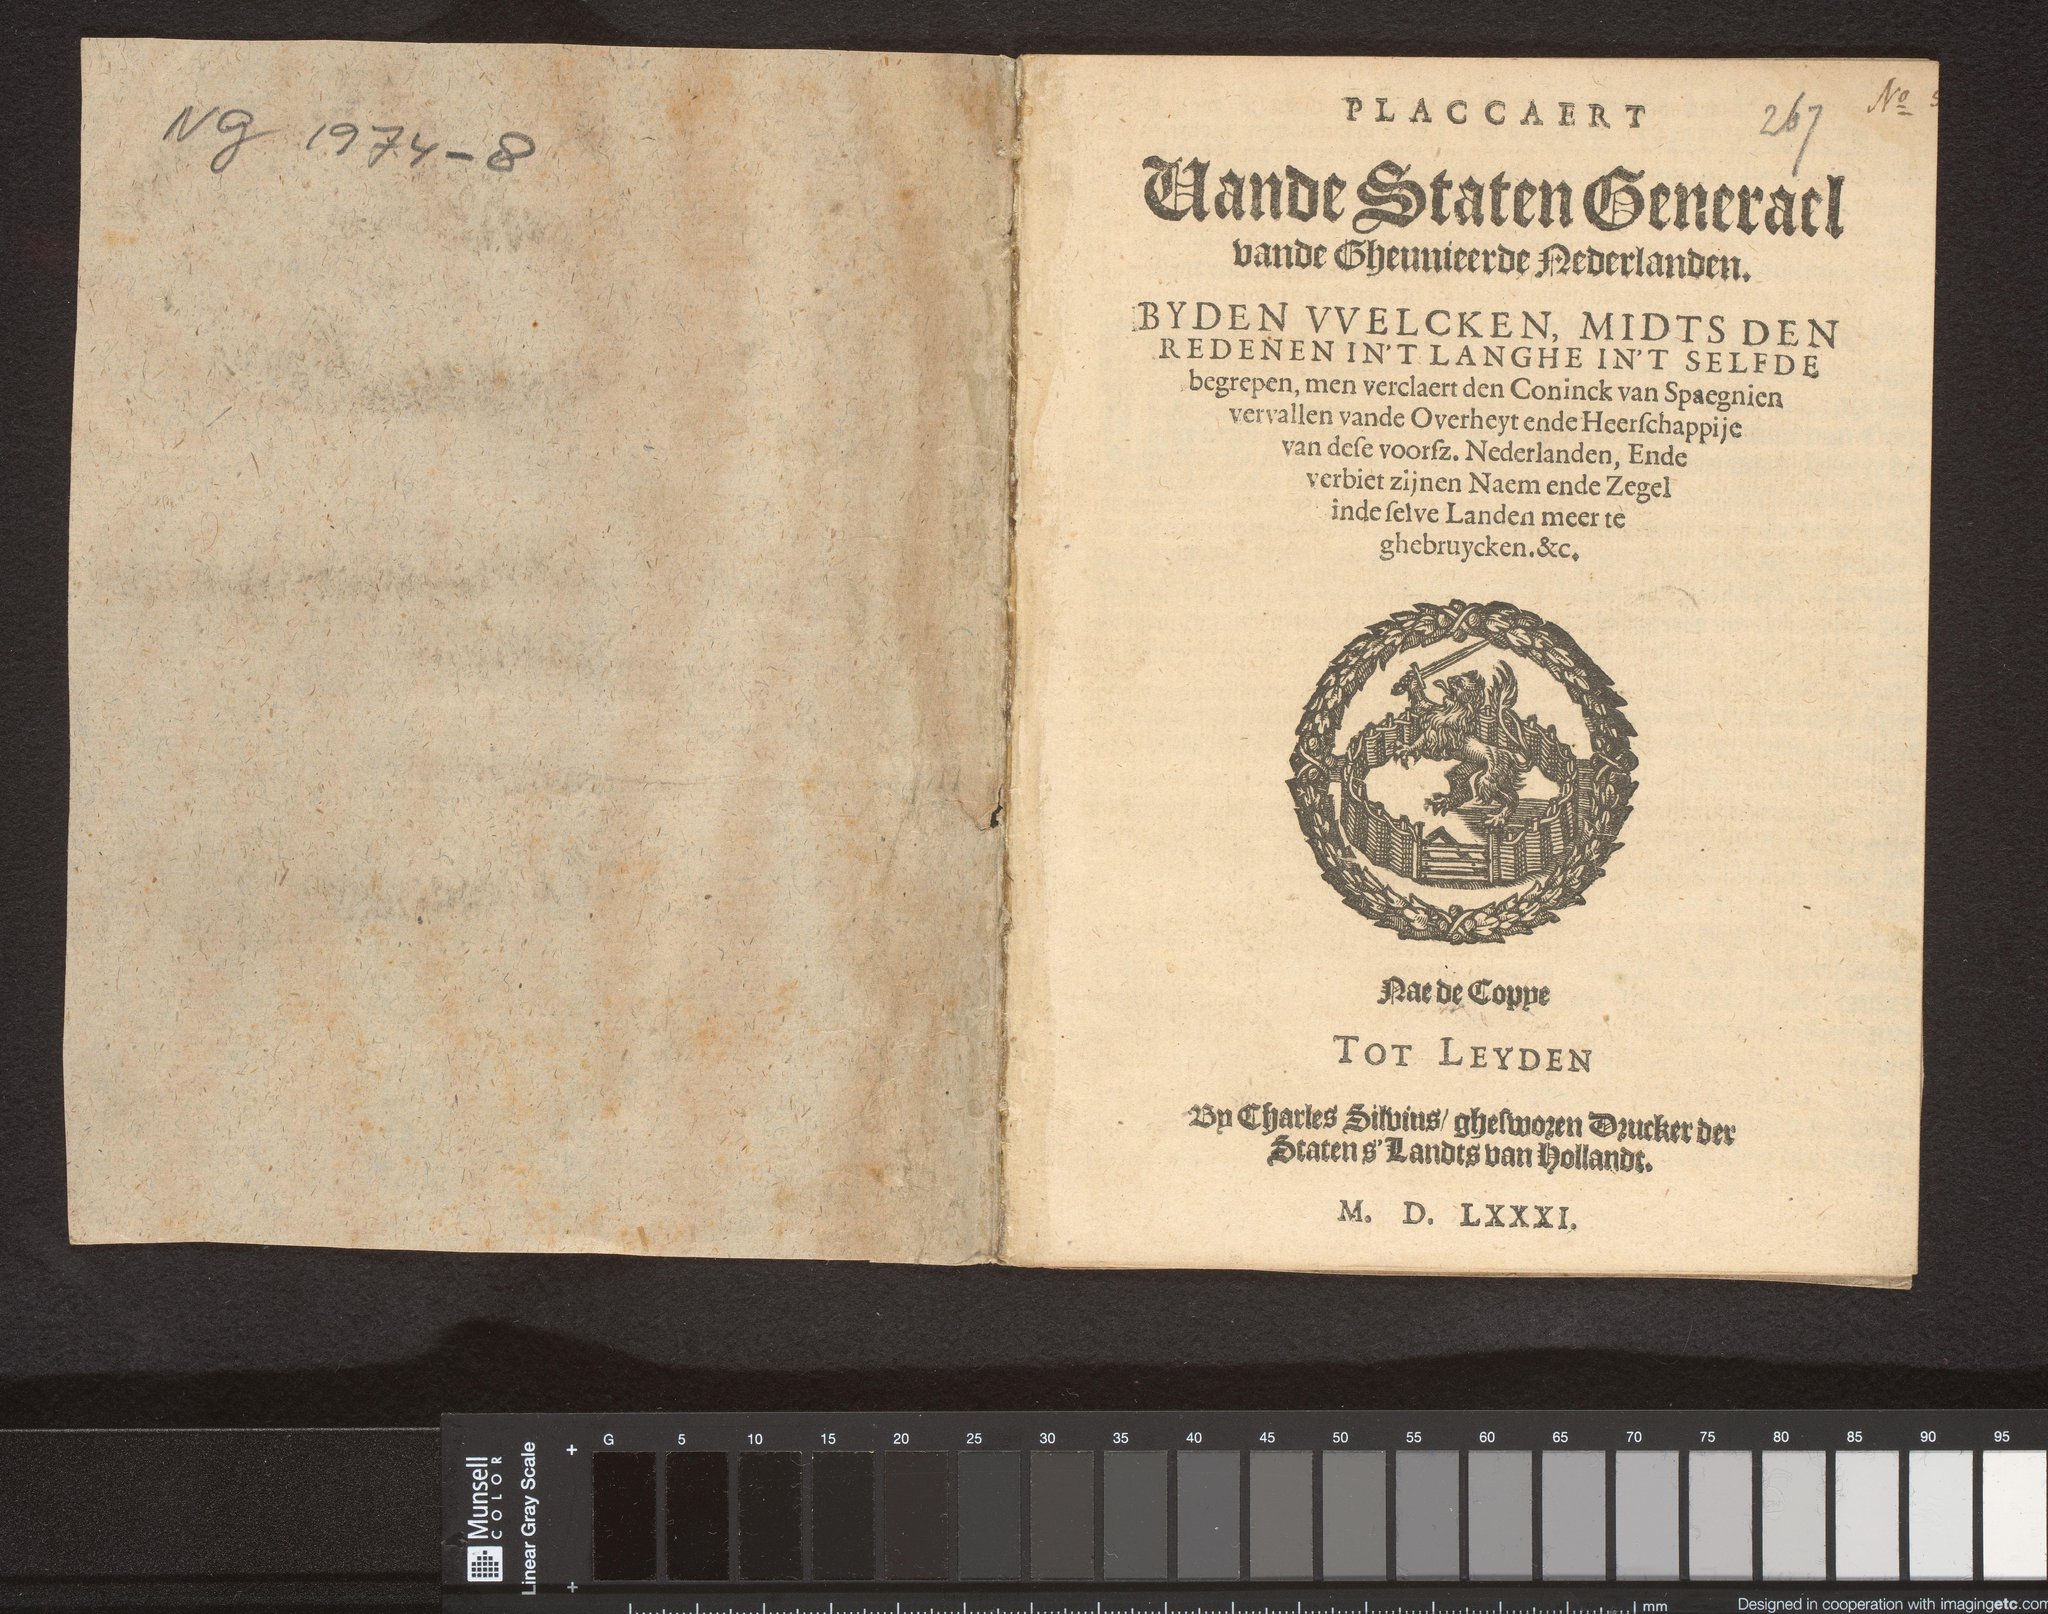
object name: brochure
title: Placcaert (...) byden welcken, midts den redenen in 't lange in 't selfde begrepen, men verclaert den Coninck van Spaengien vervallen van de Overheyt ende Heerschappije (...)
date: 1581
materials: paper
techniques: printing, sewing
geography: leiden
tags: netherlands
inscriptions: date